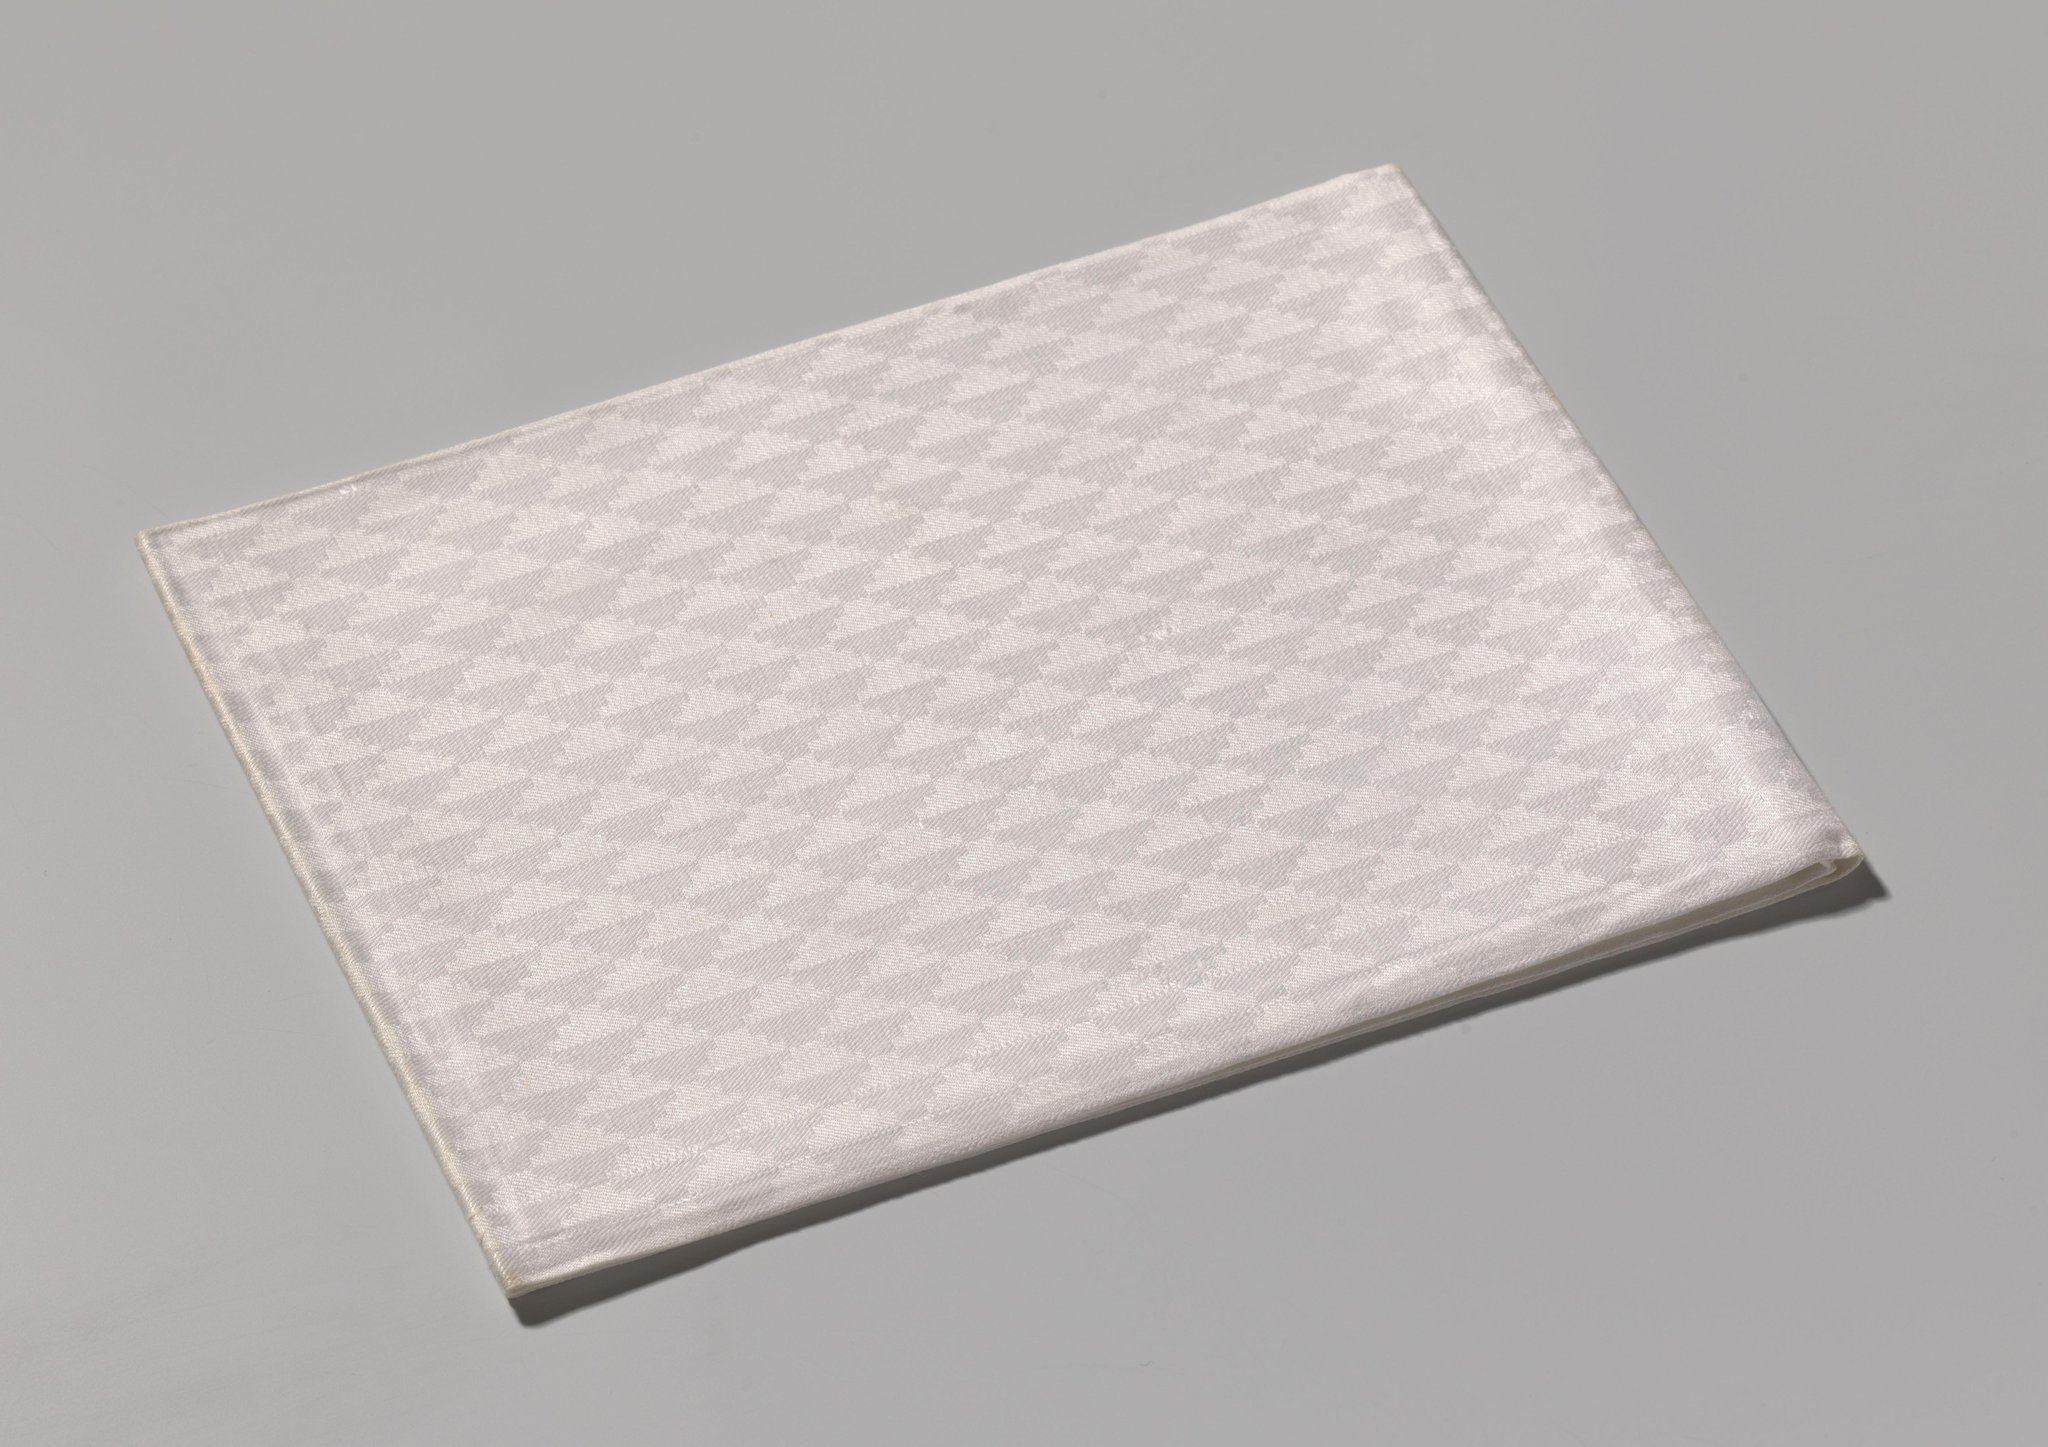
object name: napkin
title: Servet van linnen met pellenpatroon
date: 1767-1816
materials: linen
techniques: peeled fabric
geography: northern netherlands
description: Wit linnendamasten servet met pellenpatroon, merk WS en 24.